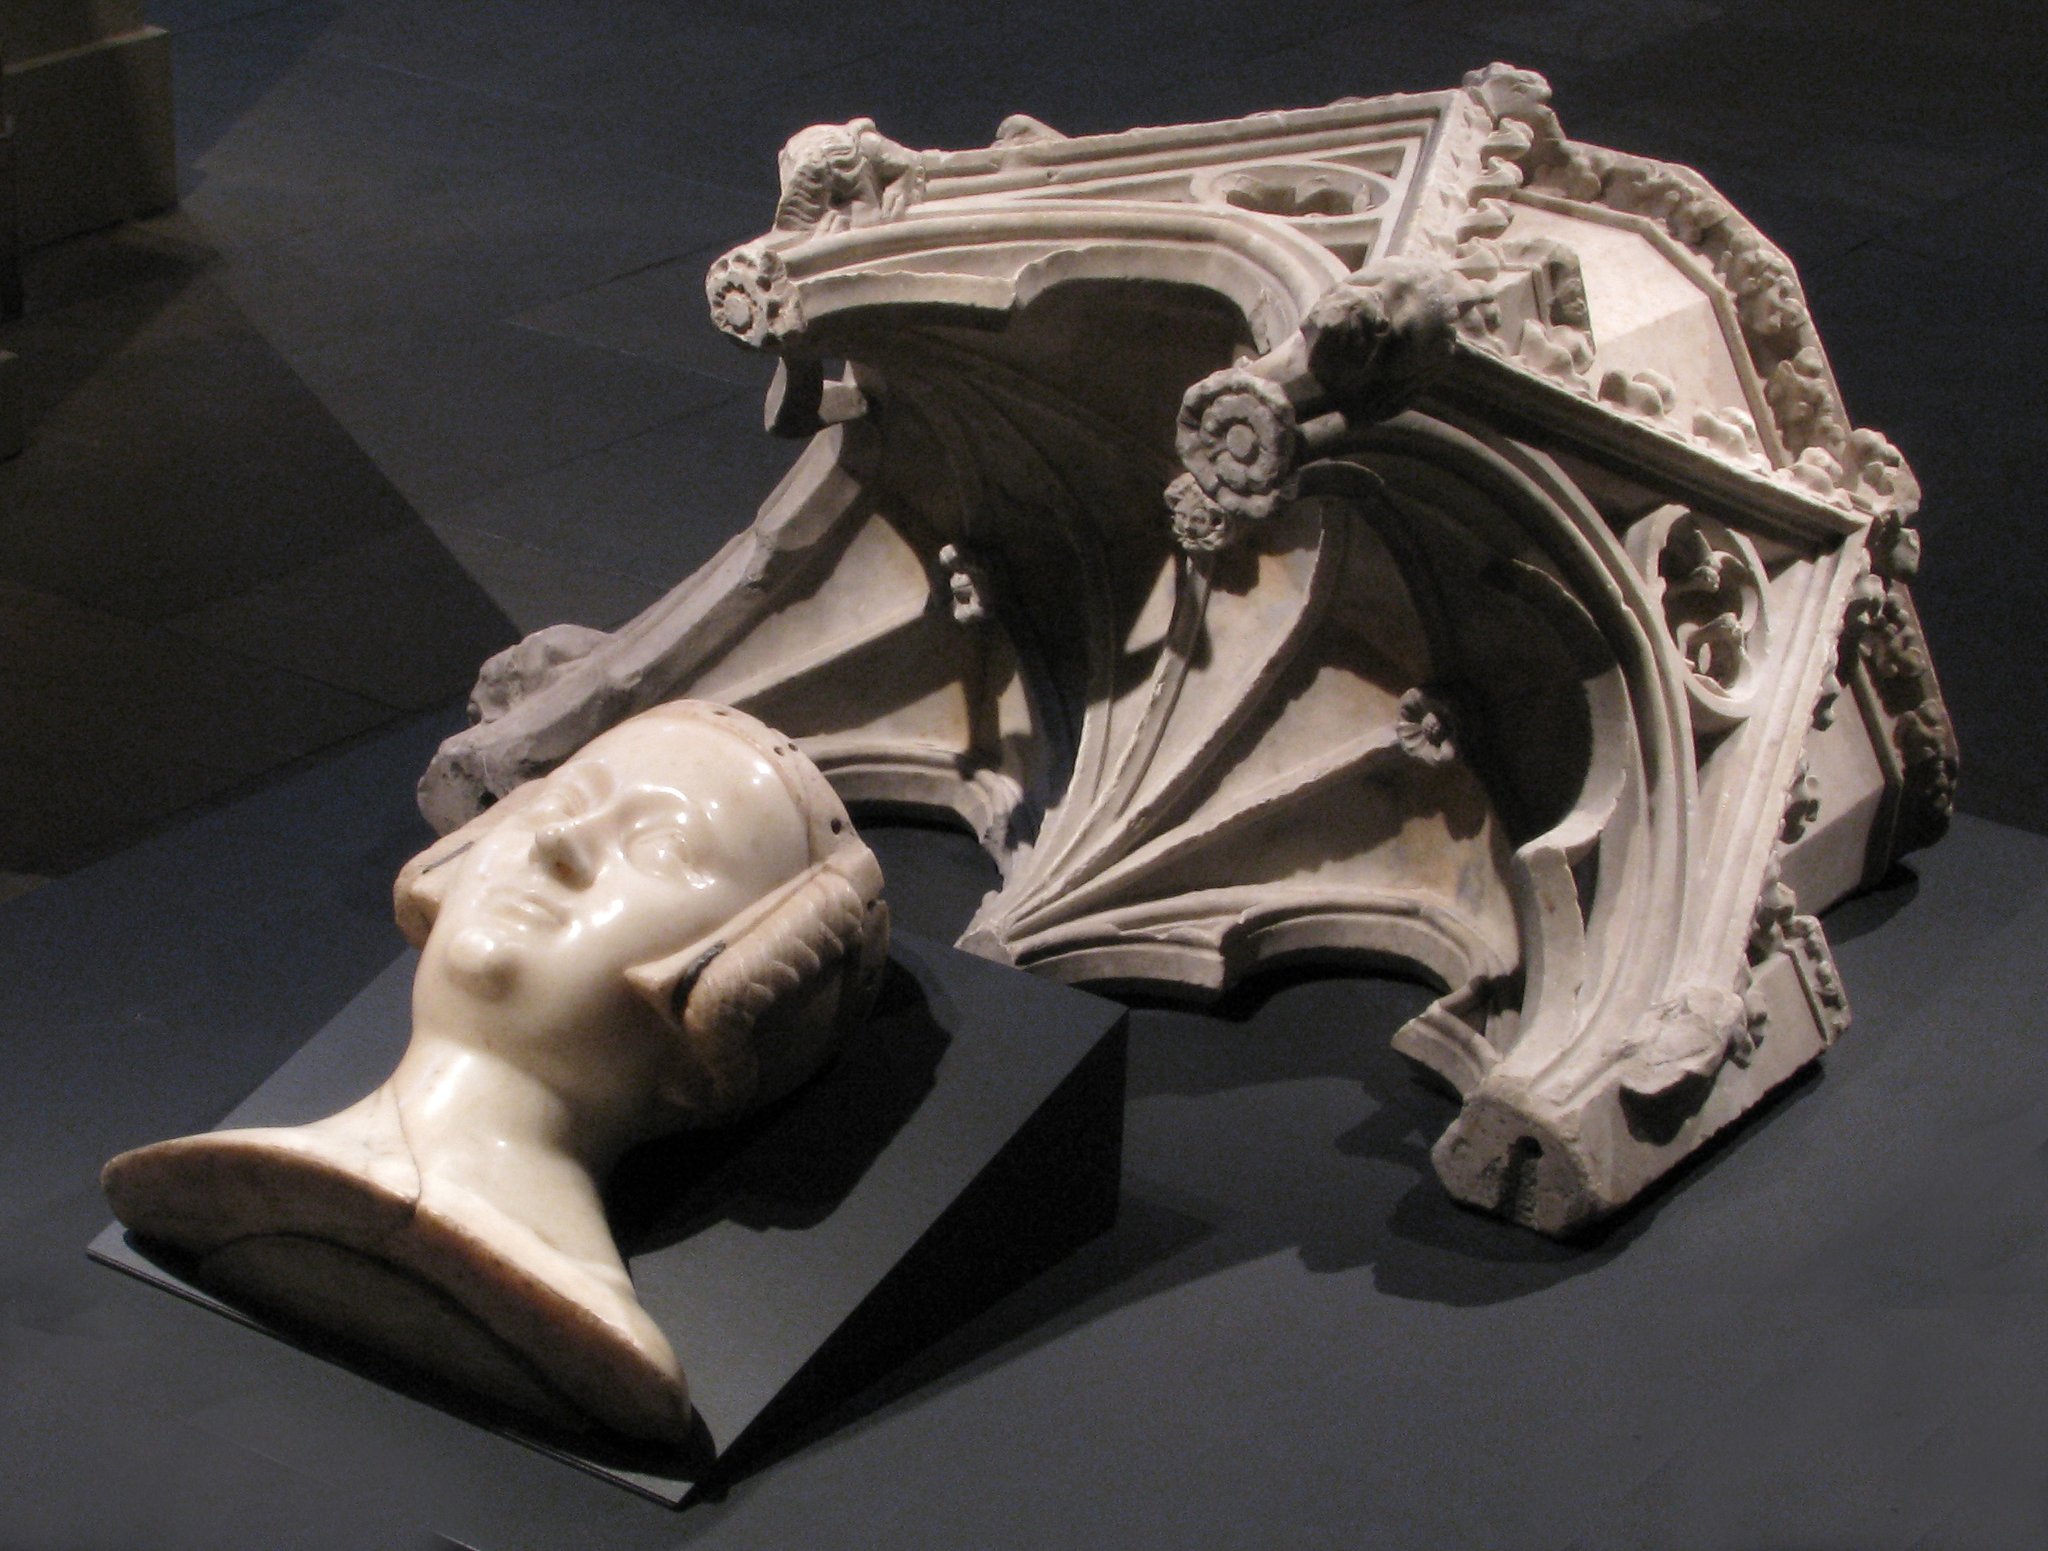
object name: tomb canopy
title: Canopy from the tomb of Philip III (the Bold) of France (1245-1285)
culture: french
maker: jean d'arras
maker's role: artist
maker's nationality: french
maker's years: 1250-1350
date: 1297-1307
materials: marble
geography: france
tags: heads,men